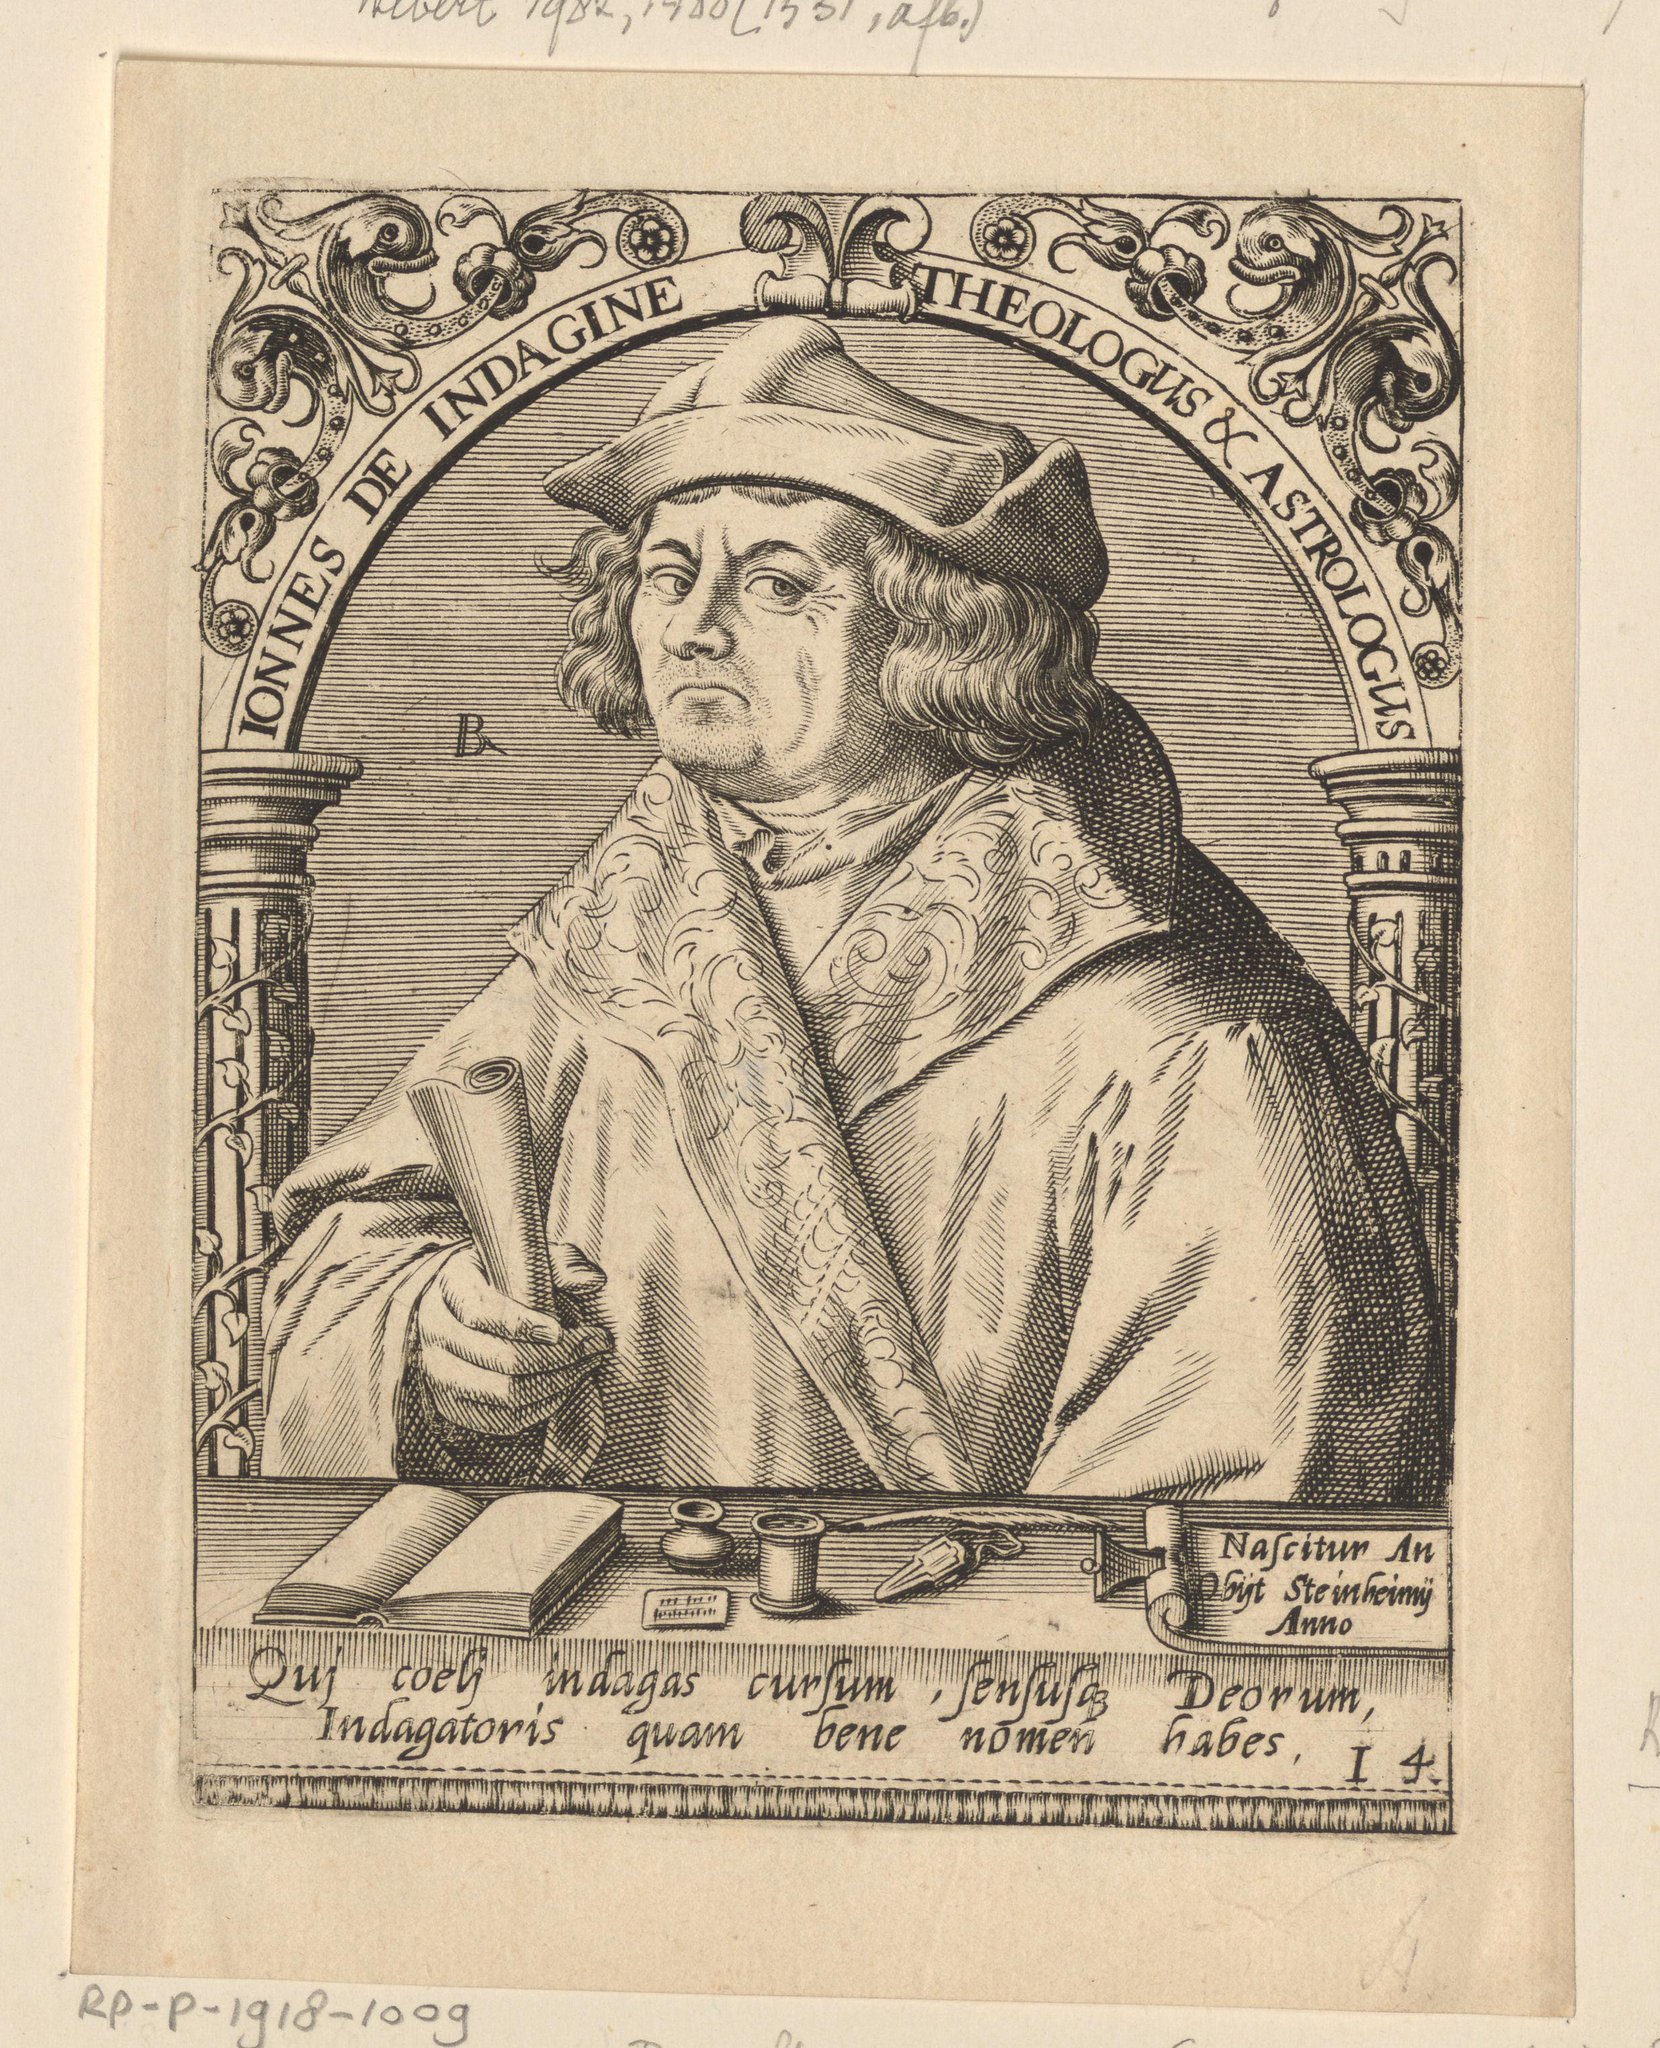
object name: print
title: Portret van Johannes Indagine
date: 1650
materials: paper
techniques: engraving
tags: theologian, historical persons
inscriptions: collector's mark: Lugt 2233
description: Prent mogelijk uit: Bibliotheca chalcographica. Frankfurt am Main: Johannes Ammon, 1650, dl. 1. Eerdere staat van prent verschenen in: Boissard, Jean Jacques. Icones quinquaginta virorum illustrium doctrina & eruditione praestantium ad vivum effictae. 4 dln. Frankfurt am Main: s.n., 1597-1599. Mogelijk ook gebruikt in latere edities.